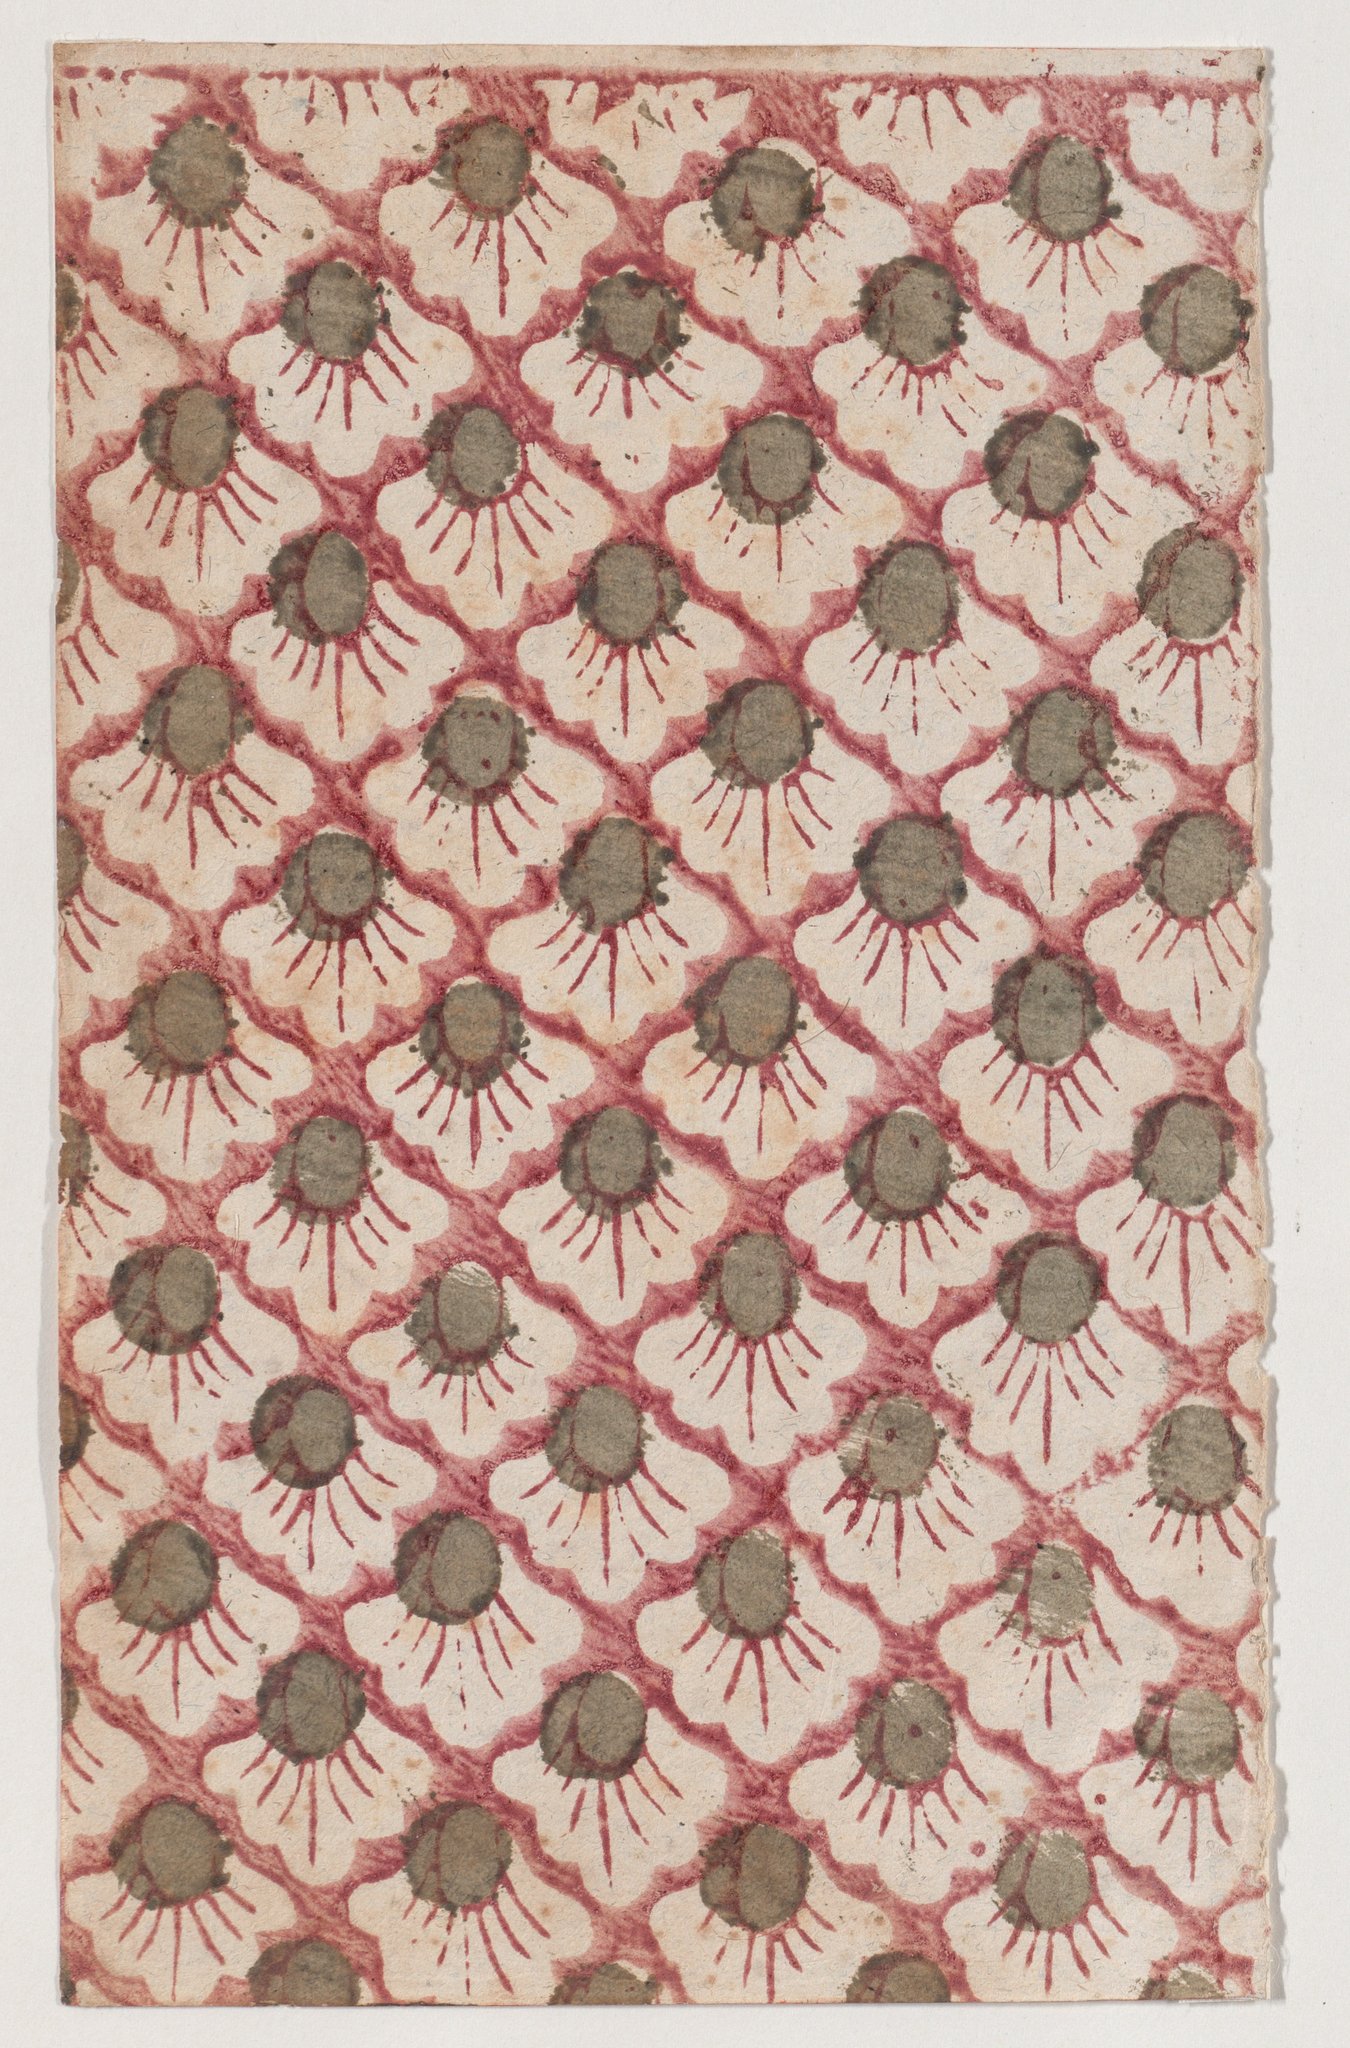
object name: print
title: Sheet with overall pattern of petals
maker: Anonymous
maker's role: artist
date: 1801-1900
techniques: relief print